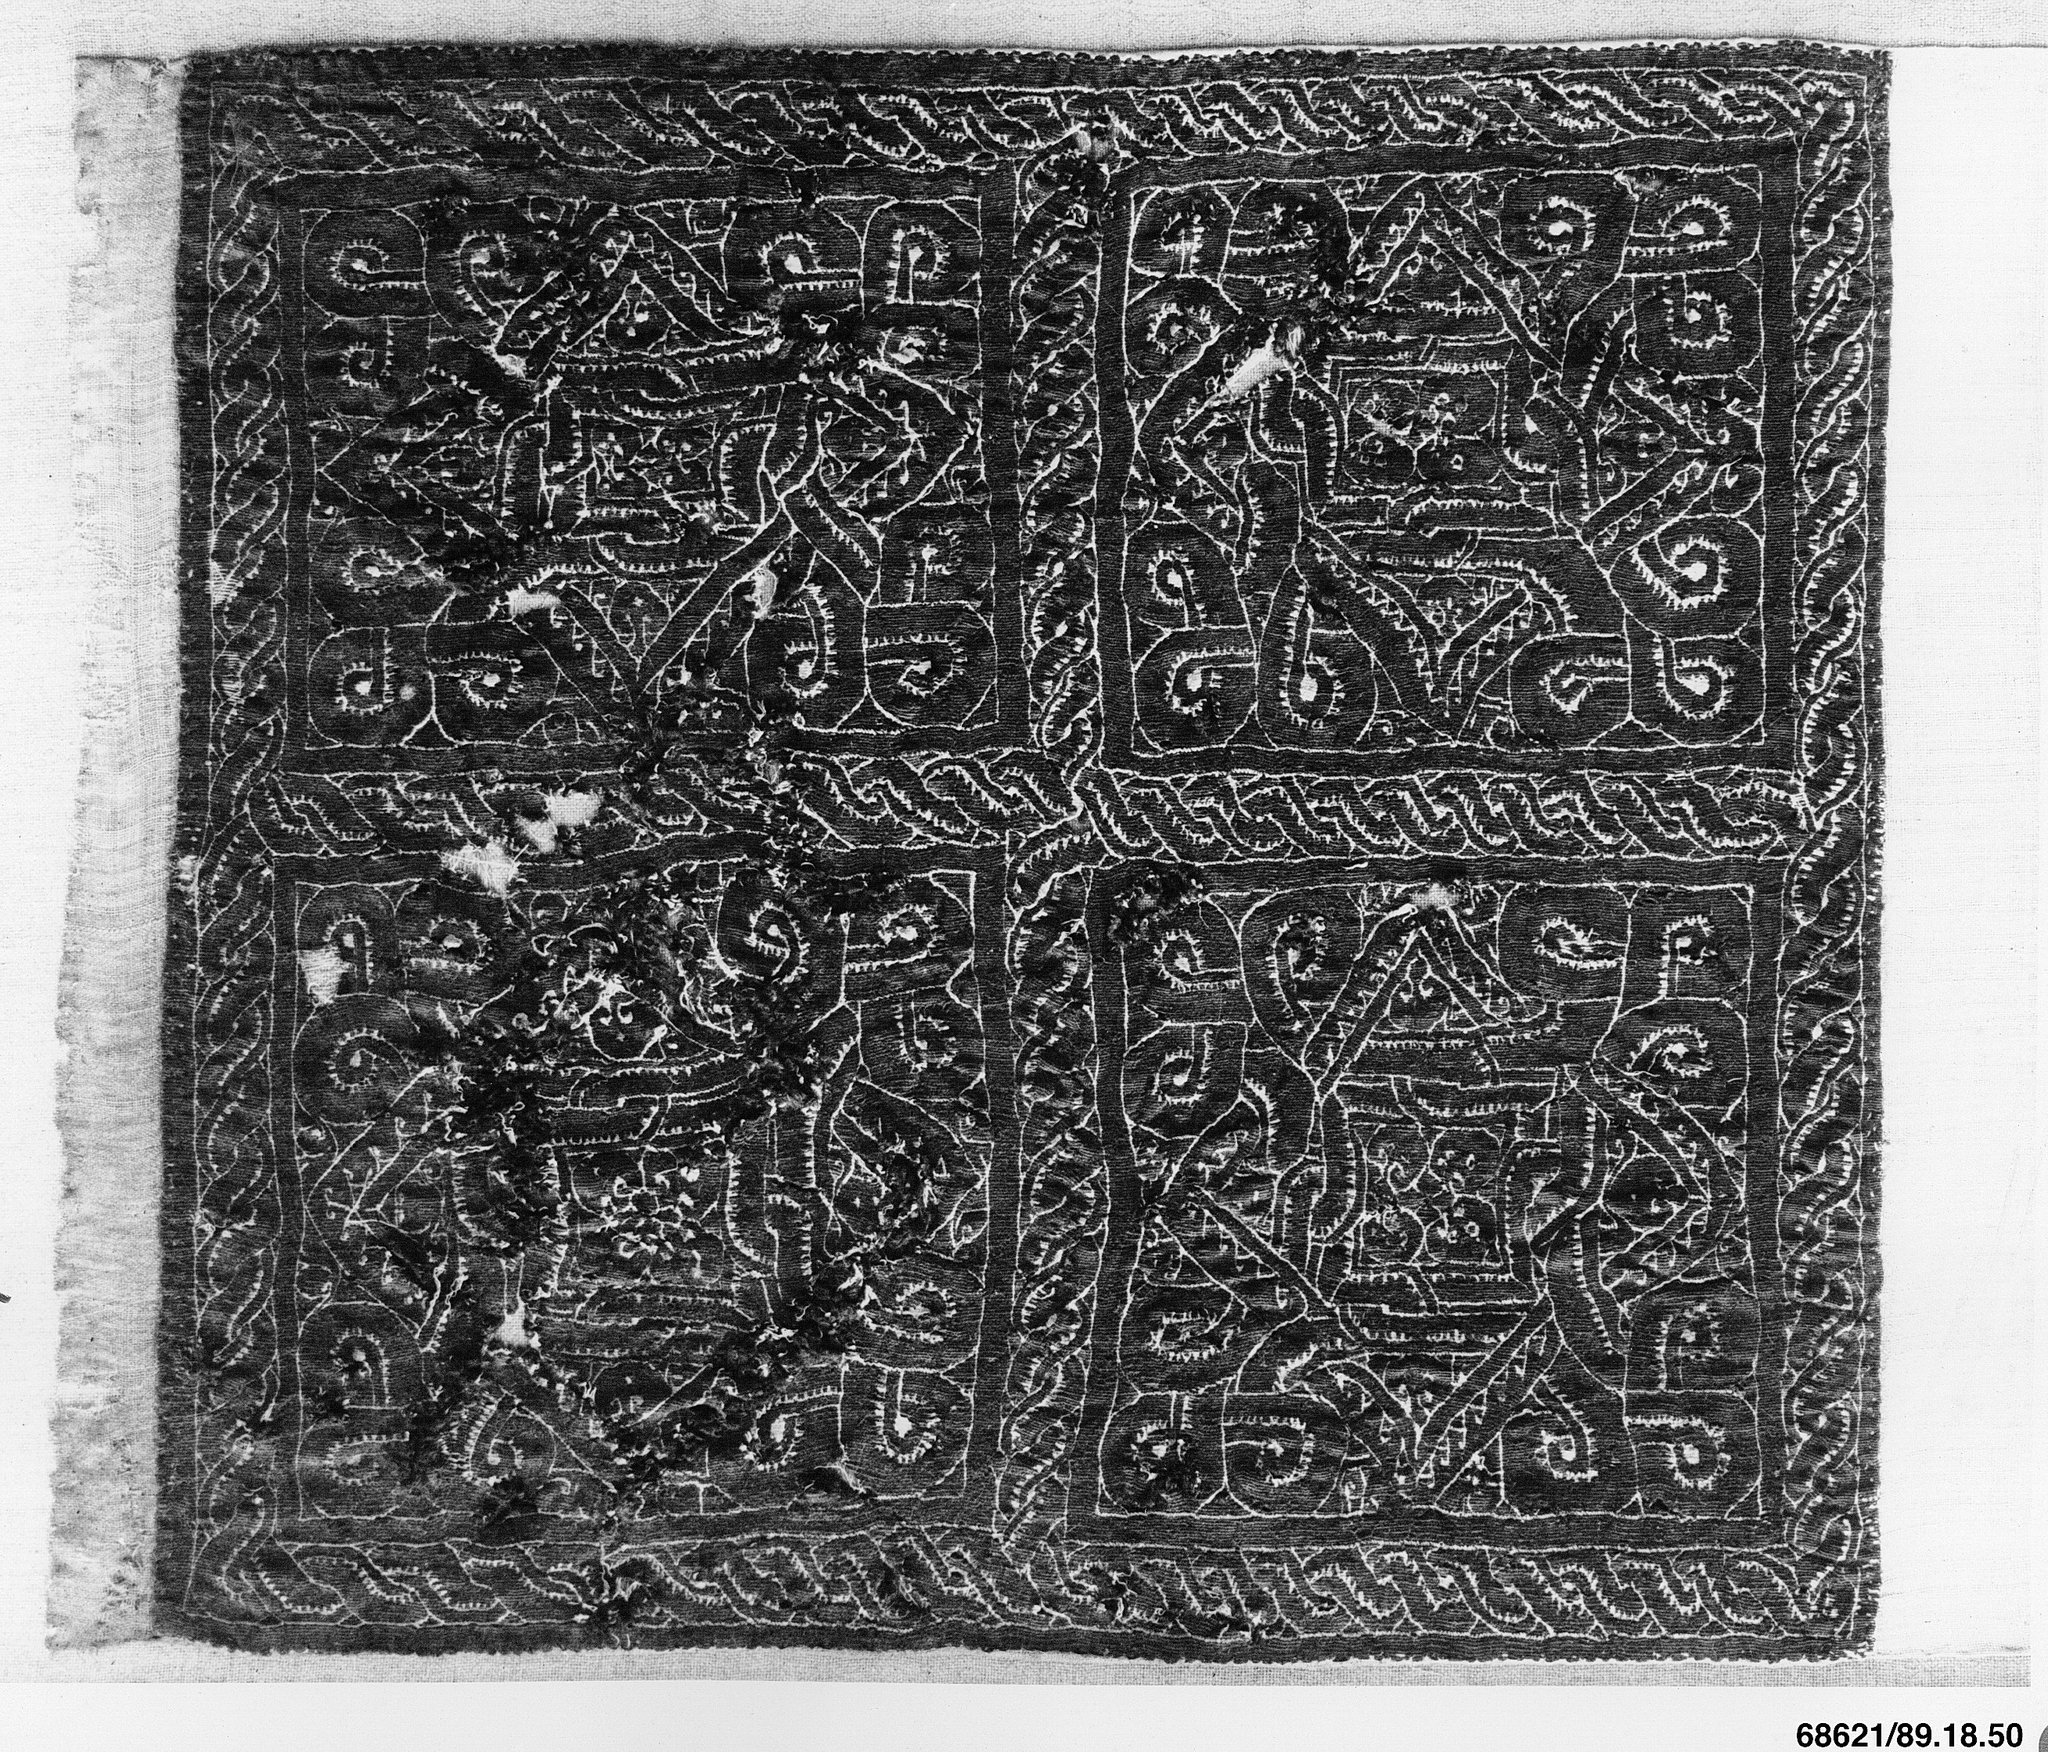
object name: textile fragment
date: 301-500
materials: linen, wool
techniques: weave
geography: egypt